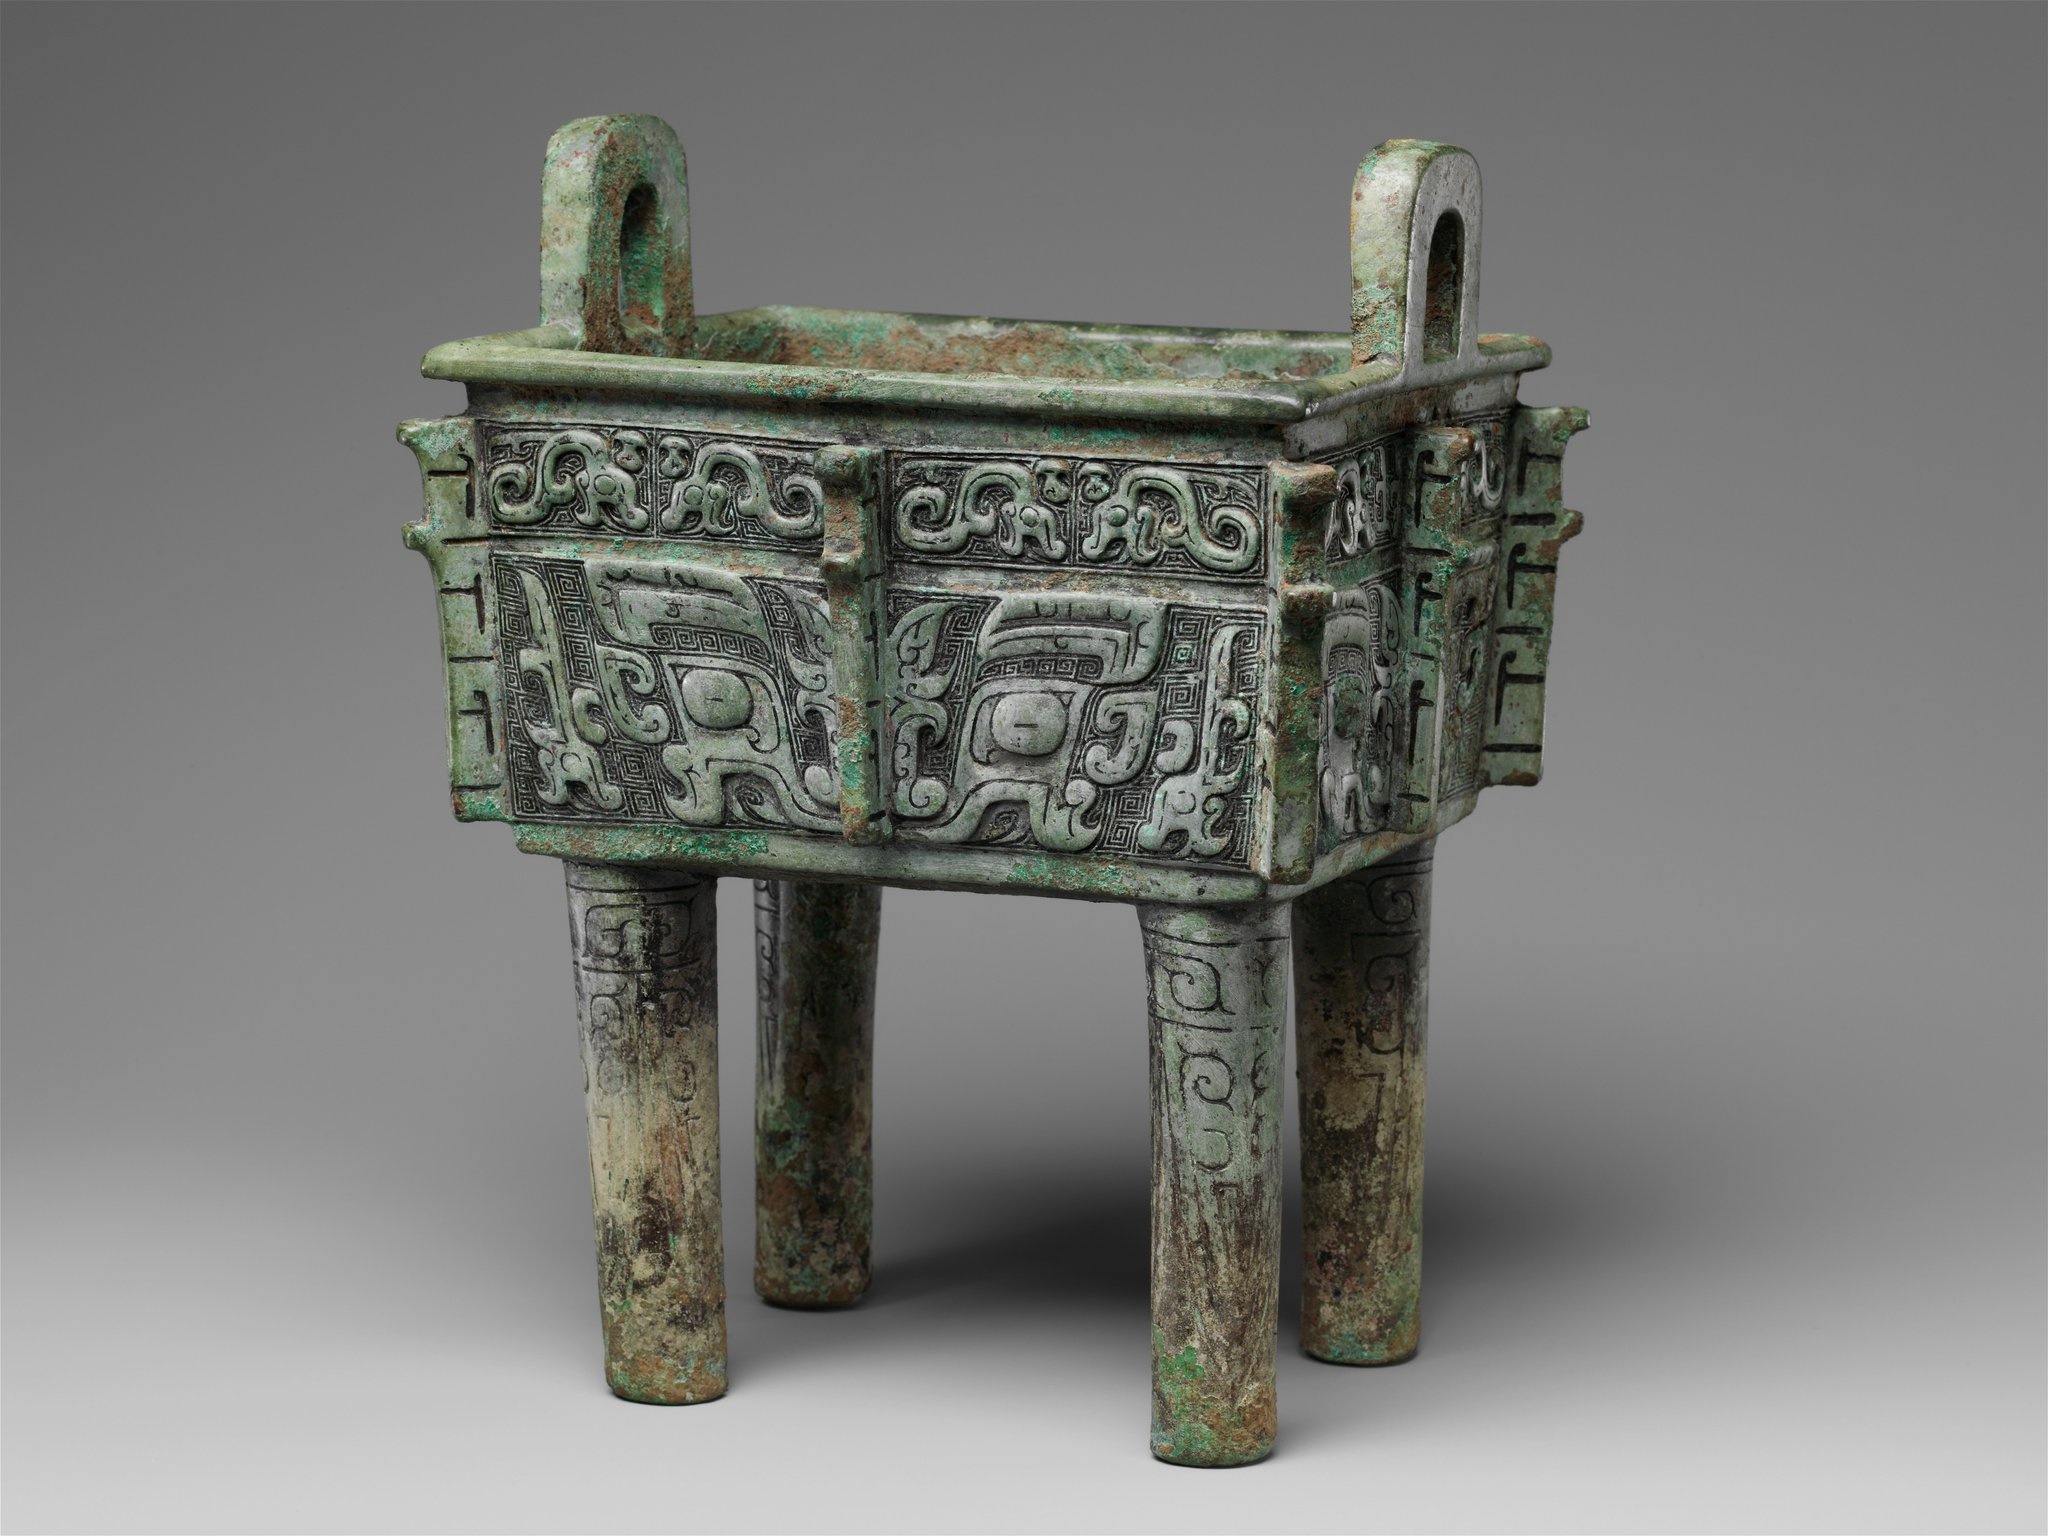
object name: cauldron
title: Rectangular cauldron (Fangding)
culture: chinese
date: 1200-1001 BCE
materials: bronze